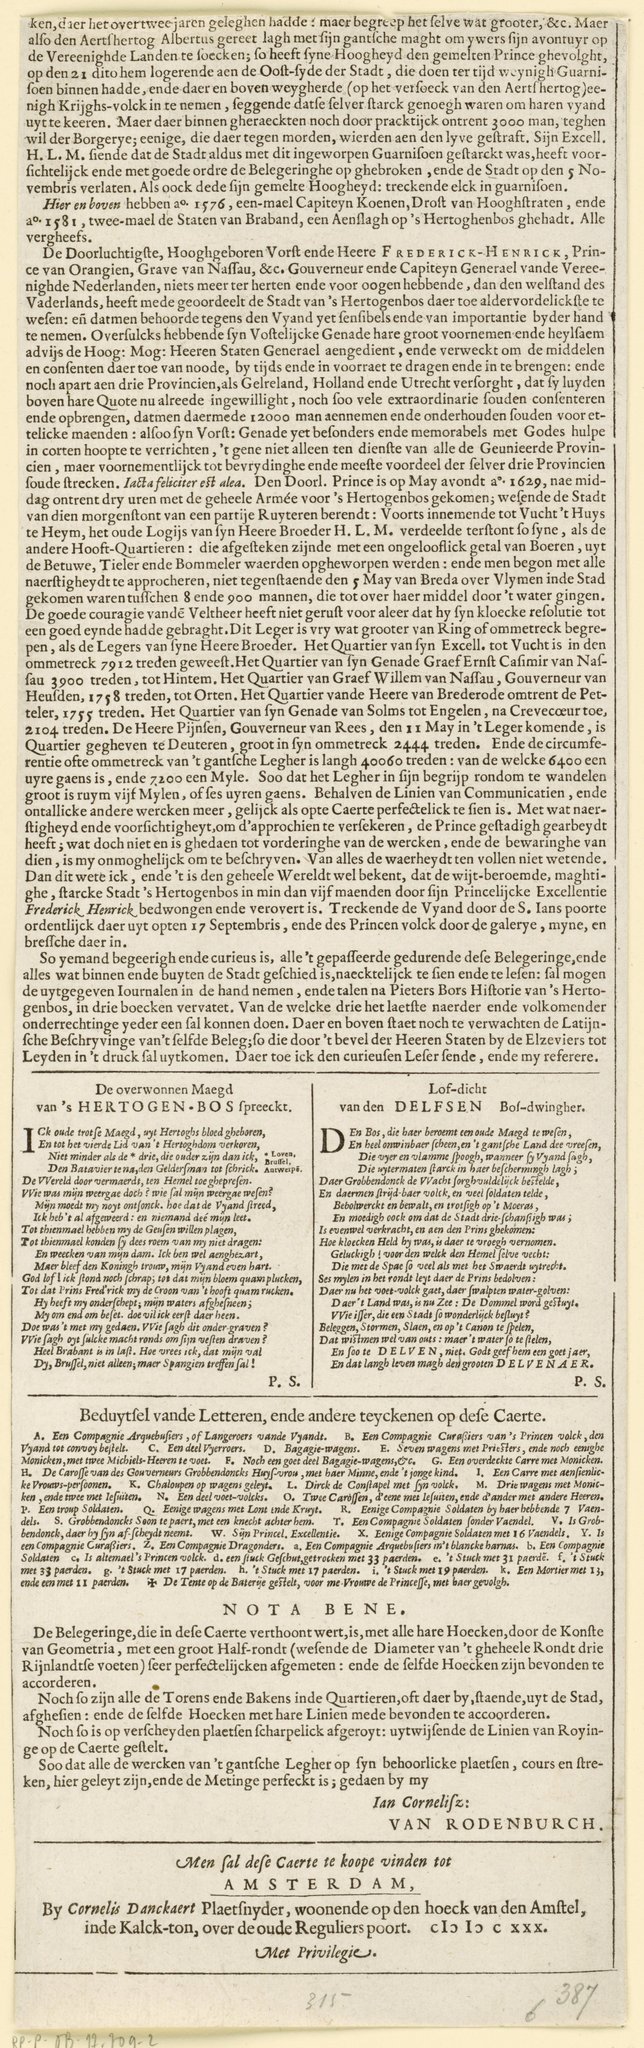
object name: text sheet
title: Beleg en inname van Den Bosch door Frederik Hendrik, 1629, (tekstblad)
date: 1630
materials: paper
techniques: letterpress printing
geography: amsterdam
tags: delft, the hague, frederick henry (prince of orange), den bosch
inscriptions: date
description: Grote kaart van de omsingeling van Den Bosch tijdens het beleg door het Staatse leger onder Frederik Hendrik, van 1 mei tot 17 september 1629. Geheel bestaande uit 4 platen en 4 tekstbladen. Tekstblad in het Nederlands met het vervolg van de beschrijving van de belegering en verovering van de stad. Onderaan enkele lofdichten.